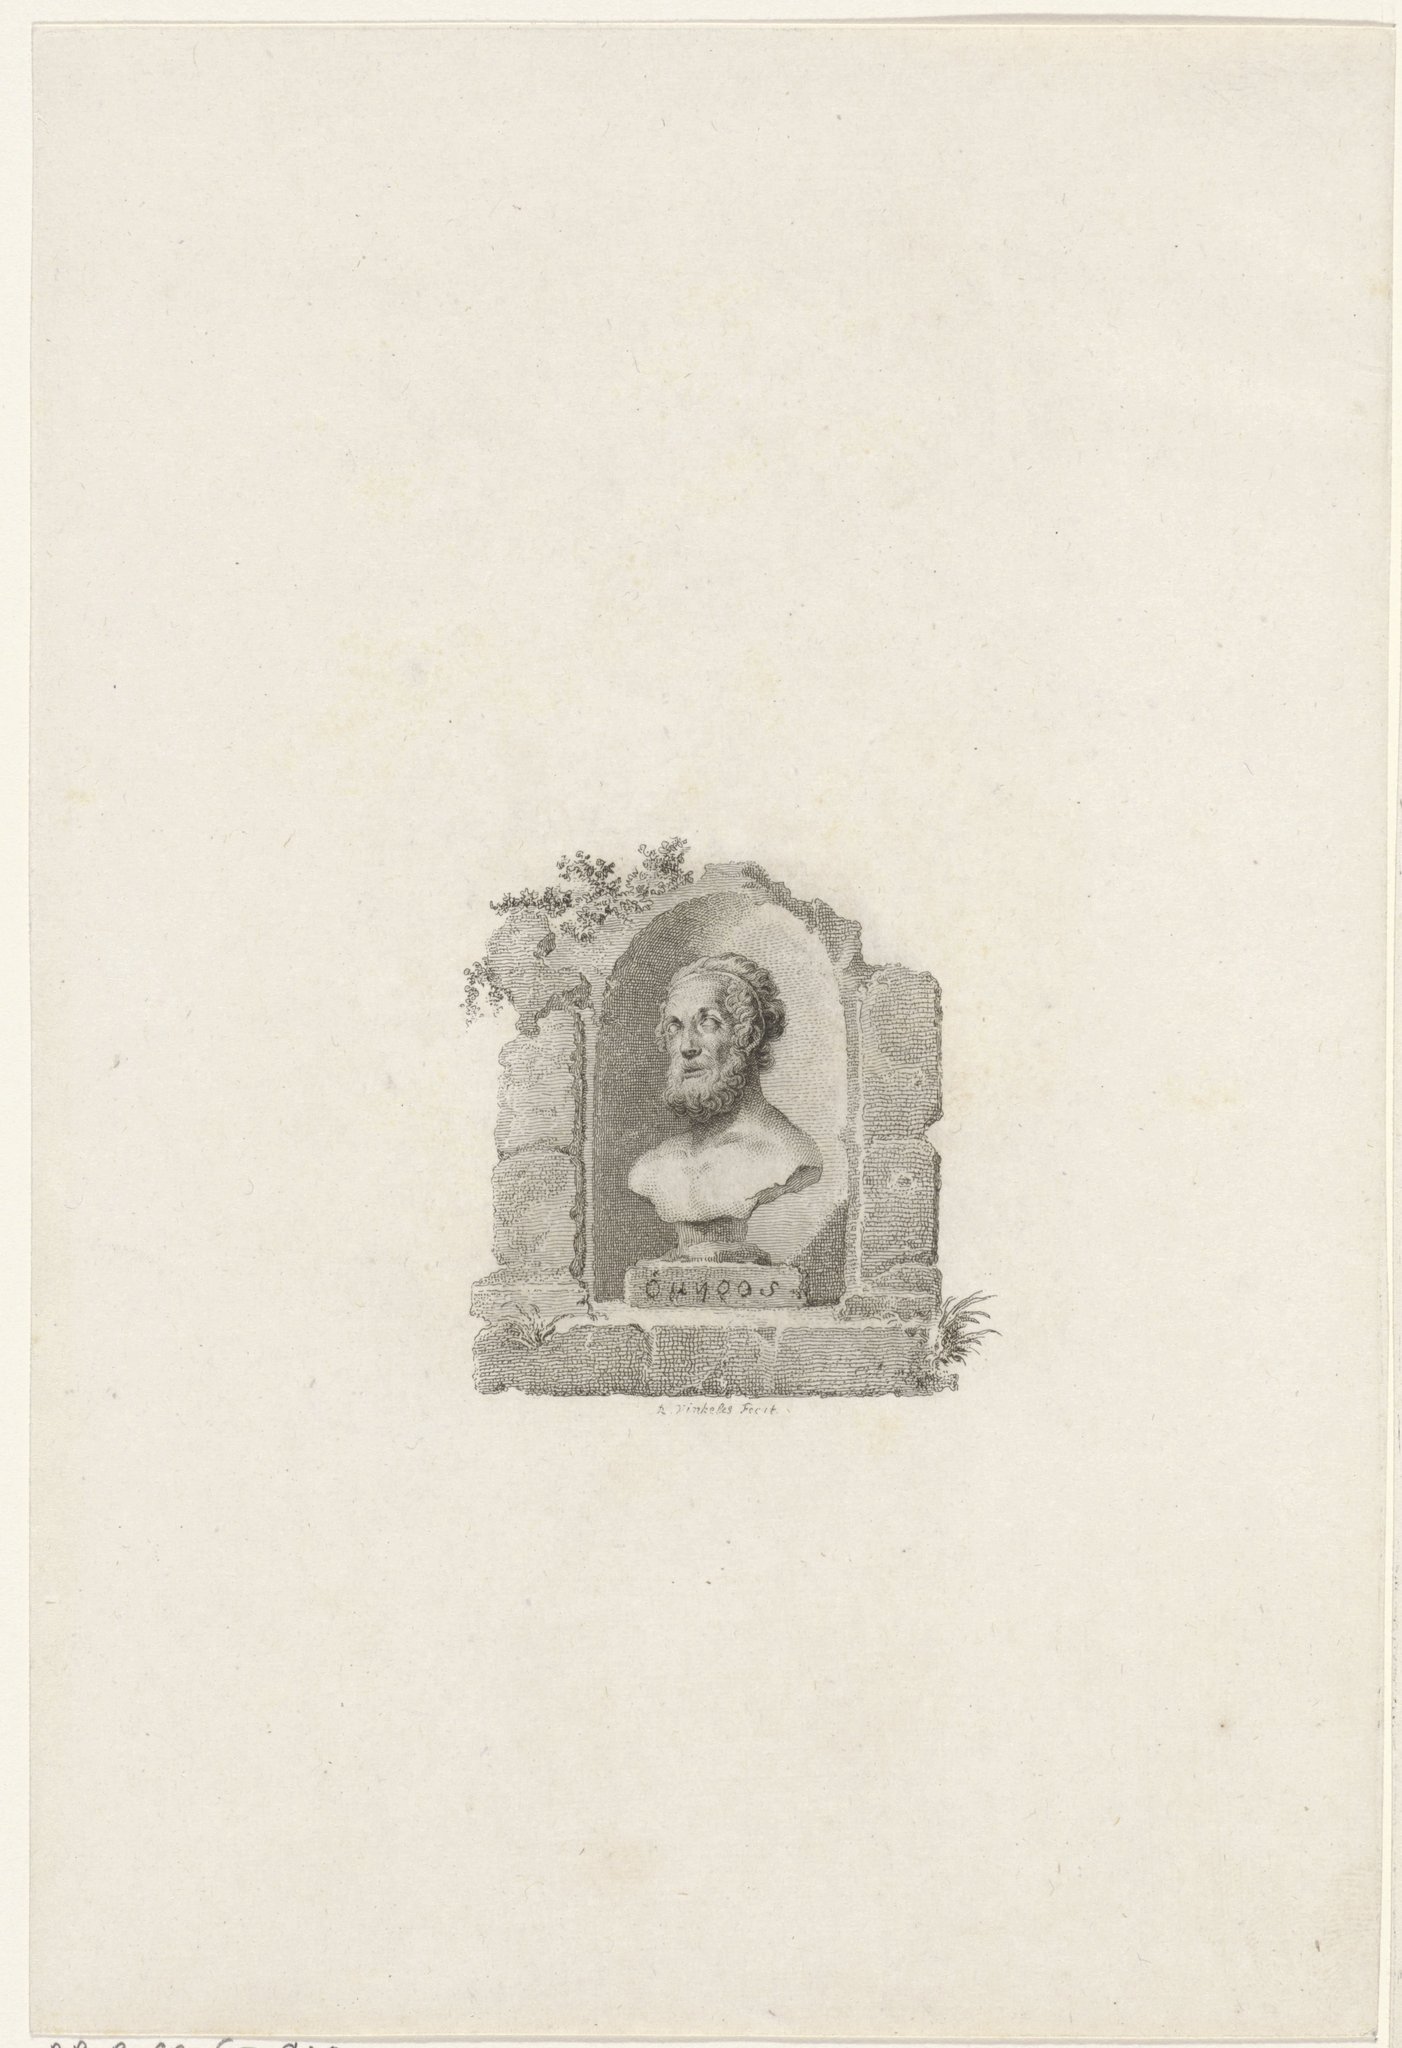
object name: print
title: Buste van een man in een nis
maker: reinier vinkeles (i)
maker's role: draughtsman, print maker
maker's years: 1741-1816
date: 1751-1816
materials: paper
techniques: engraving, etching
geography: amsterdam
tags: statues, sculptures in garden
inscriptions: collector's mark: Lugt 2228